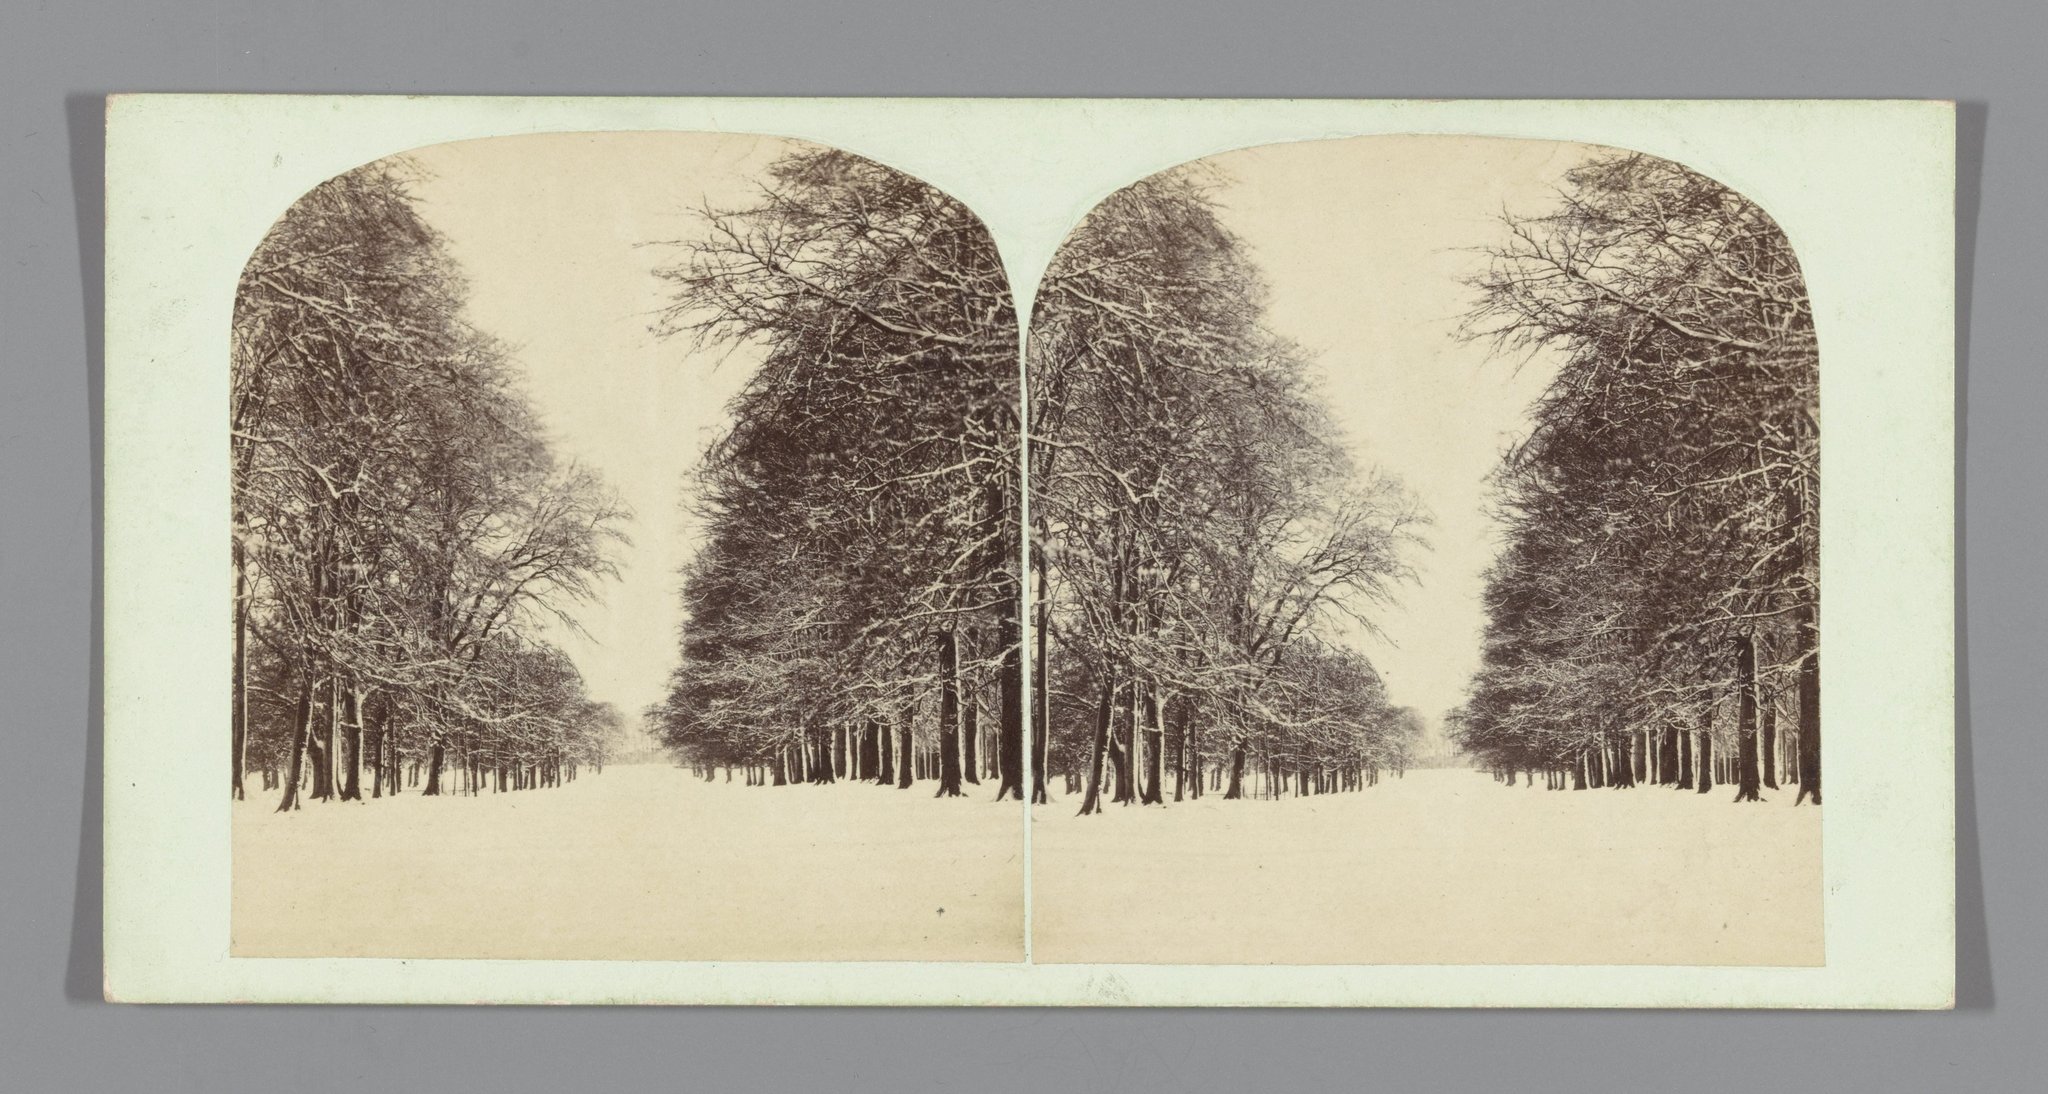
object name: stereograph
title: Besneeuwde laan (vermoedelijk) te Engeland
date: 1850-1880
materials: cardboard, photographic support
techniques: albumen print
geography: manchester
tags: forest path or lane, snow, england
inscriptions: number: ‘No. 1025.’, name: ‘Photographed and Published by The Manschester Photographic Company, Limited, 84, Market Street, Manchester.’